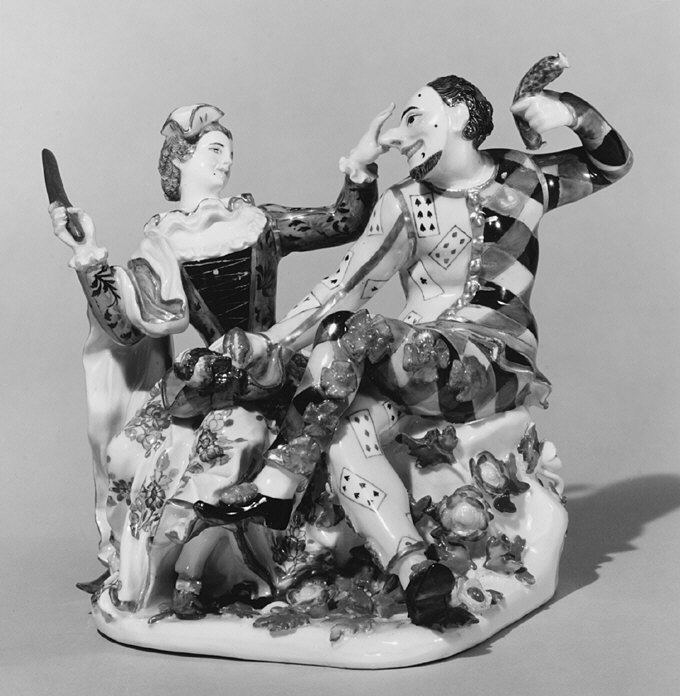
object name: group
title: Harlequin and Columbine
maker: meissen manufactory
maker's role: manufactory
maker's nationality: german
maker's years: 1710-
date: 1743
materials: hard paste porcelain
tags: men,women,playing cards